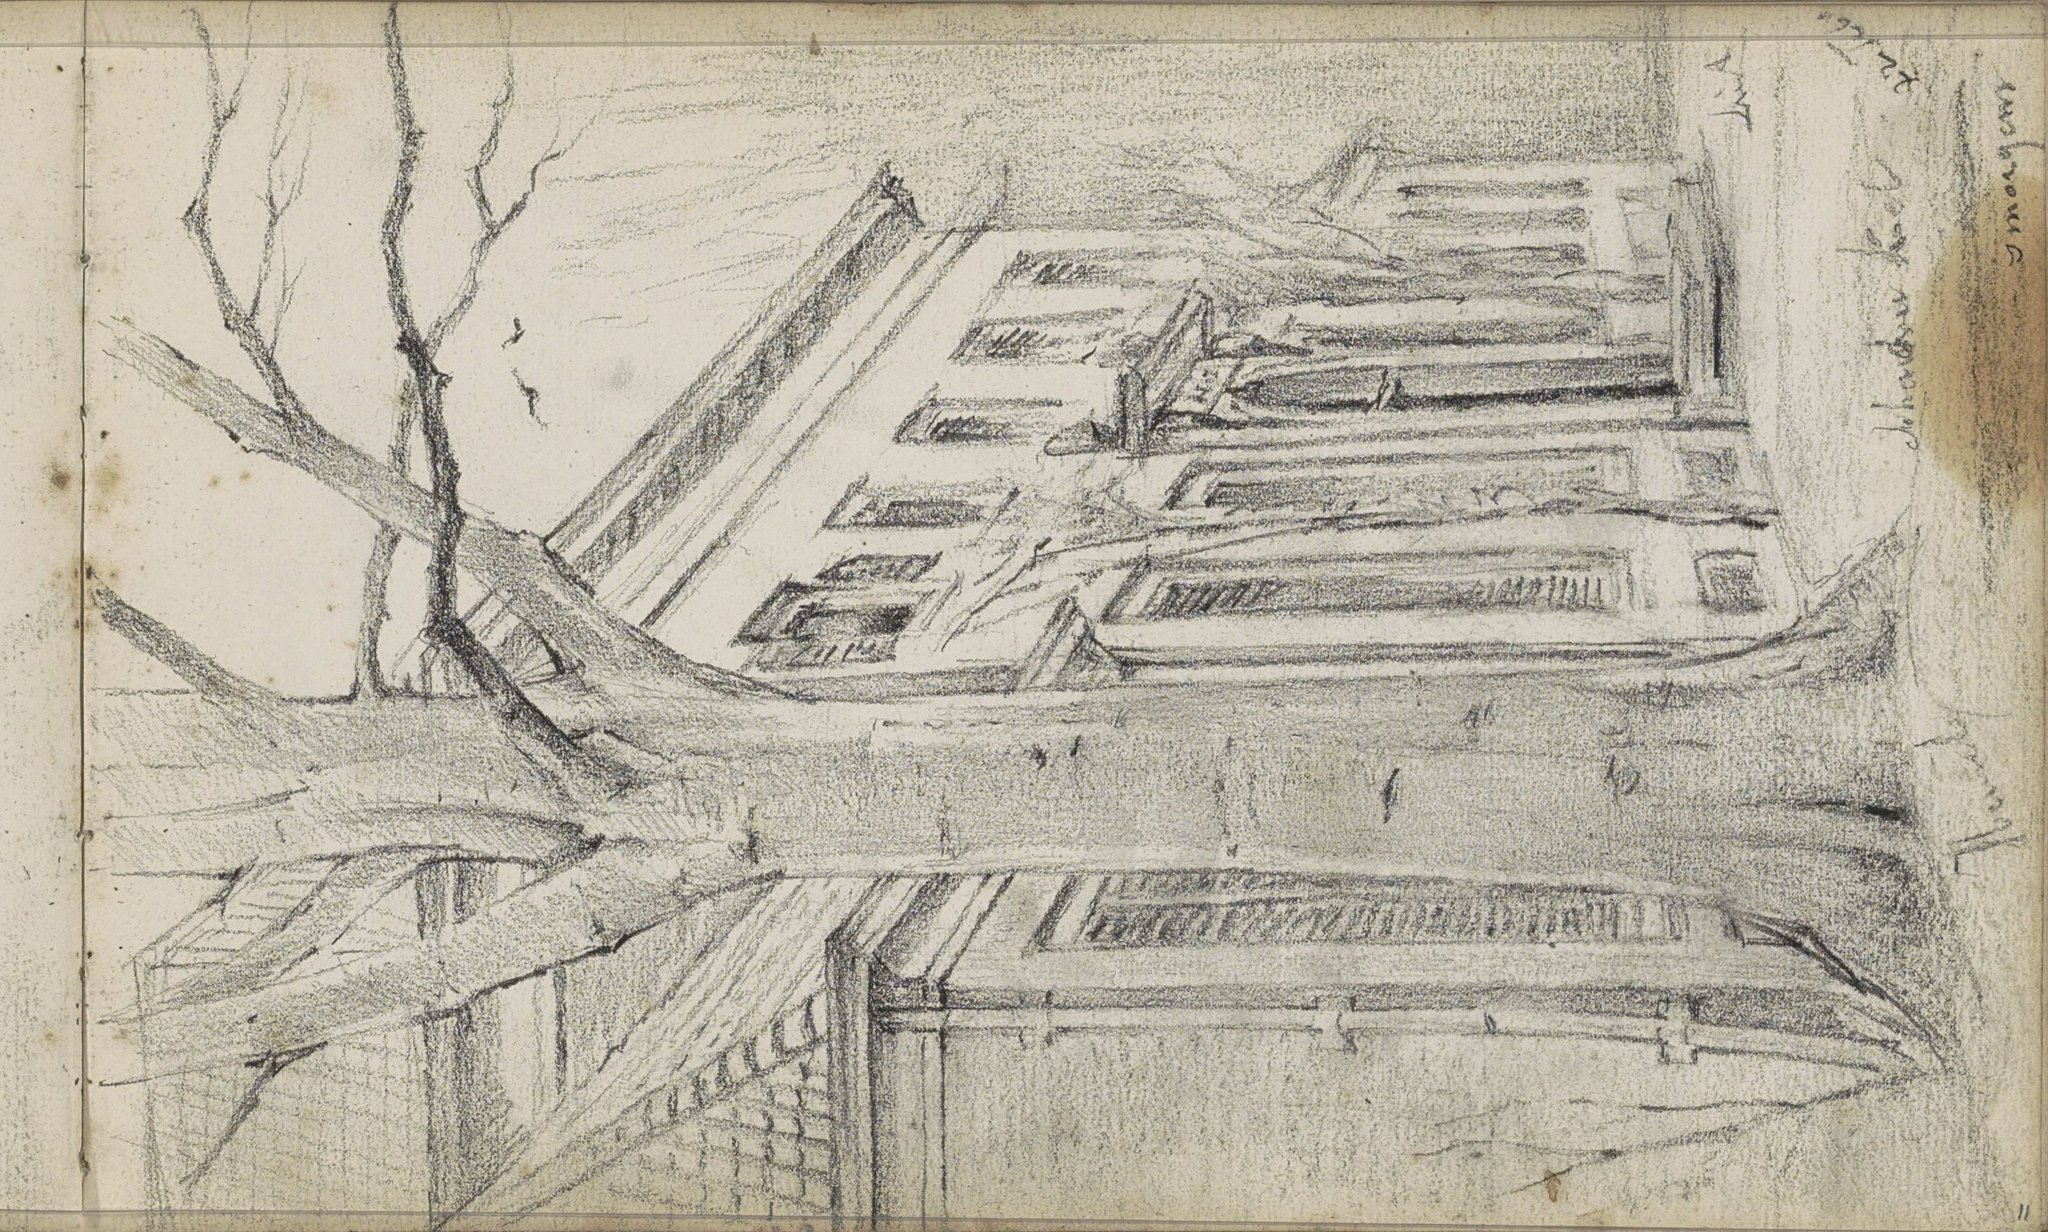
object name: sketchbook leaf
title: Gebouw met luiken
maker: willem cornelis rip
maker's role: draughtsman, painter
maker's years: 1856-1922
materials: paper, pencil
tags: window shutters on the outside, exterior ~ representation of a building, rotterdam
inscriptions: date and inscription: ‘H[...]/ s morgens/ 22 Feb’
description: Blad 11 recto uit een schetsboek met 41 bladen.